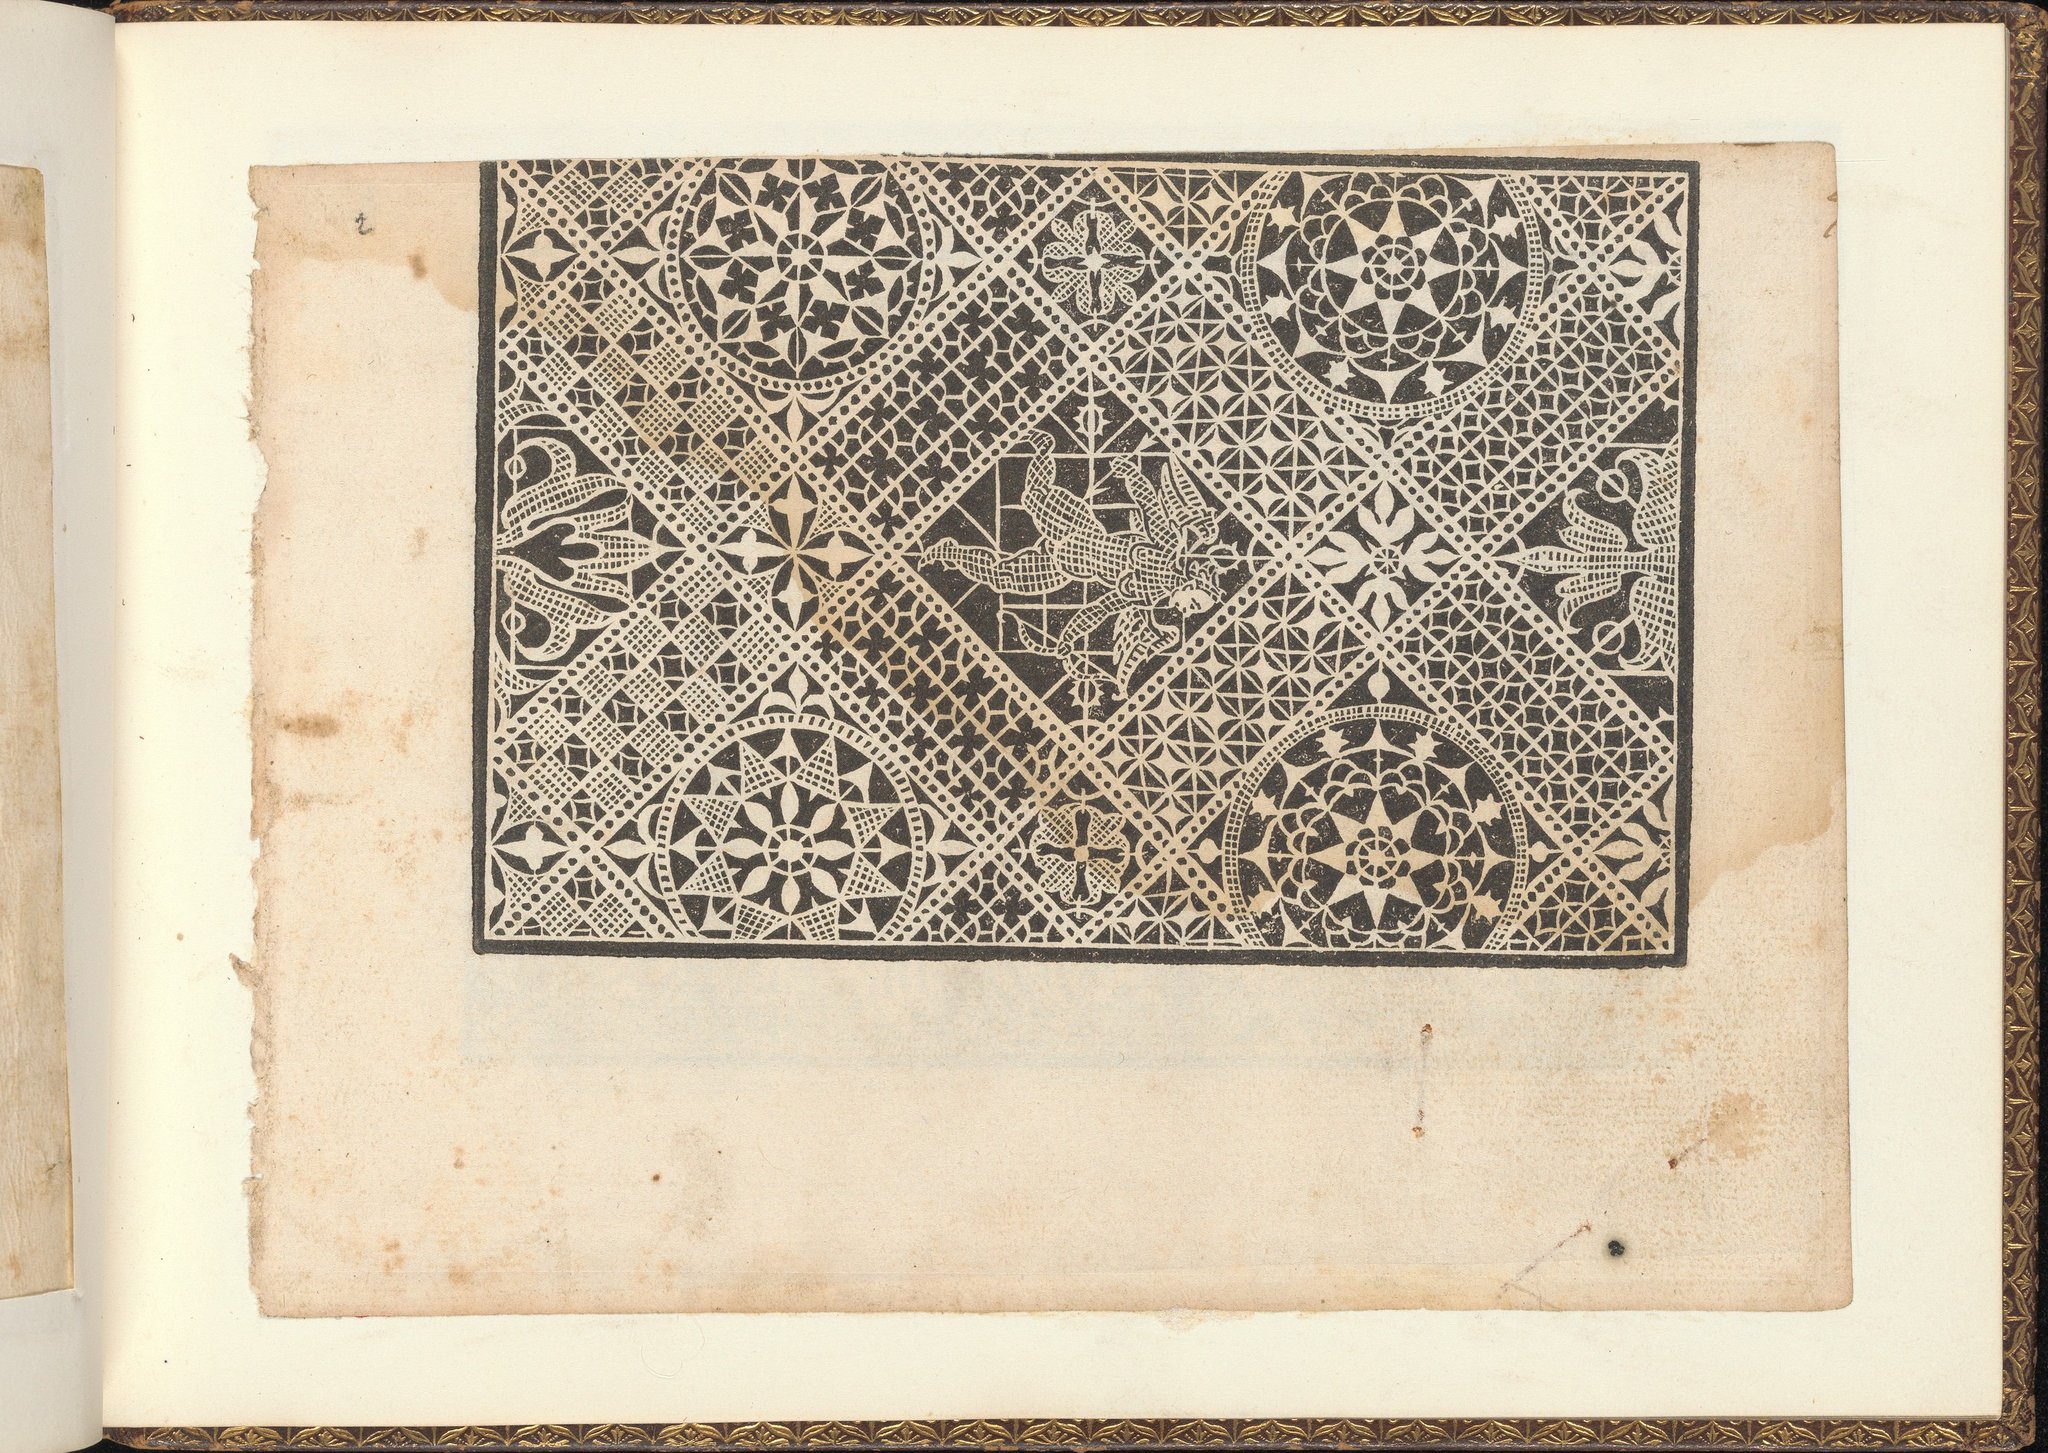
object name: book print ornament architecture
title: Prima parte de' fiori, page 3 (recto)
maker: giovanni battista ciotti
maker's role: author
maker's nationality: italian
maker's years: 1555-1659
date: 1591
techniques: woodcut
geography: italy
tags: ornament